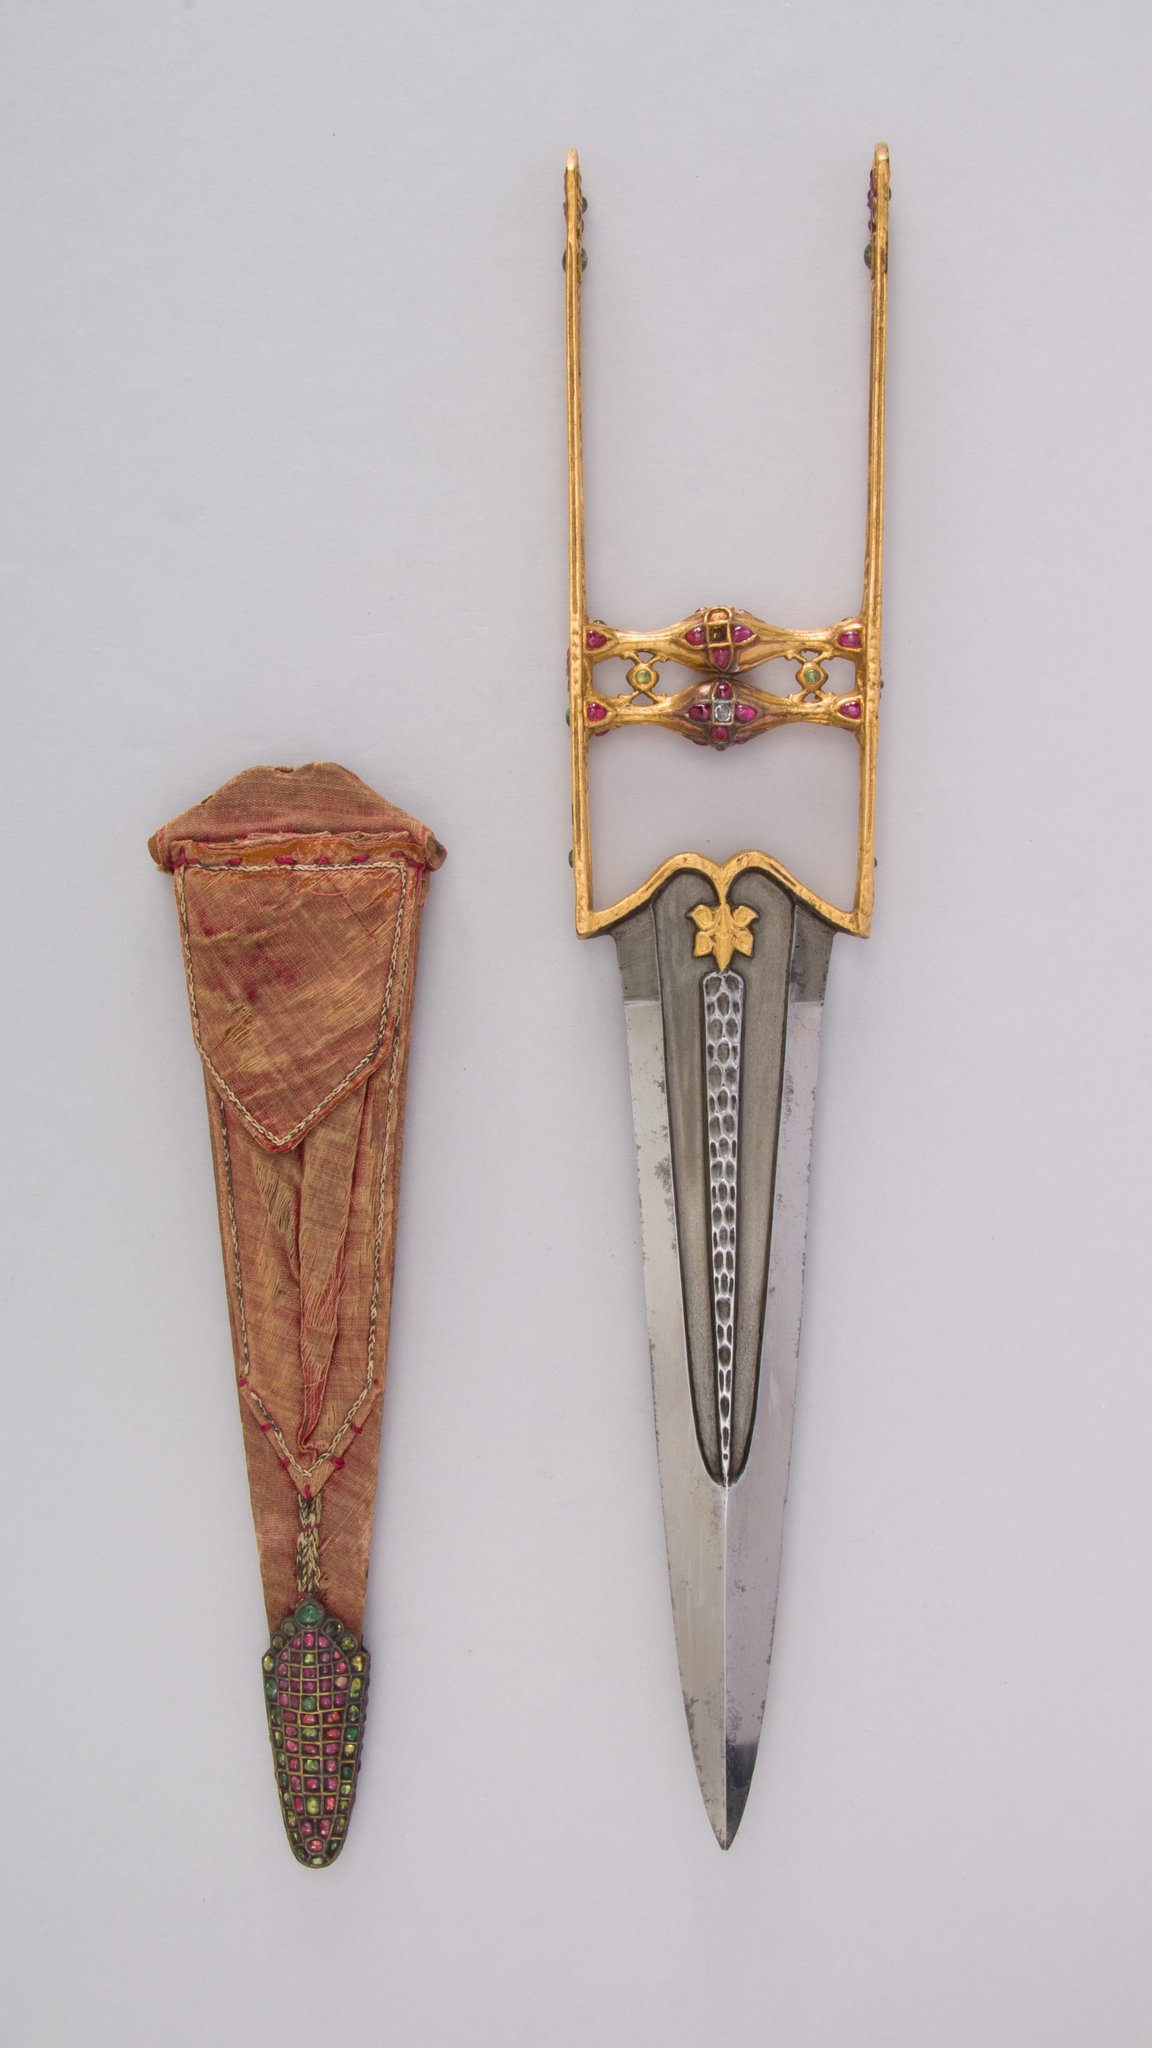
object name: dagger with sheath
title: Dagger (Katar) with Sheath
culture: indian, mughal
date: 1701-1900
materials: diamond, gemstone, gold, steel, velvet, wood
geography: india